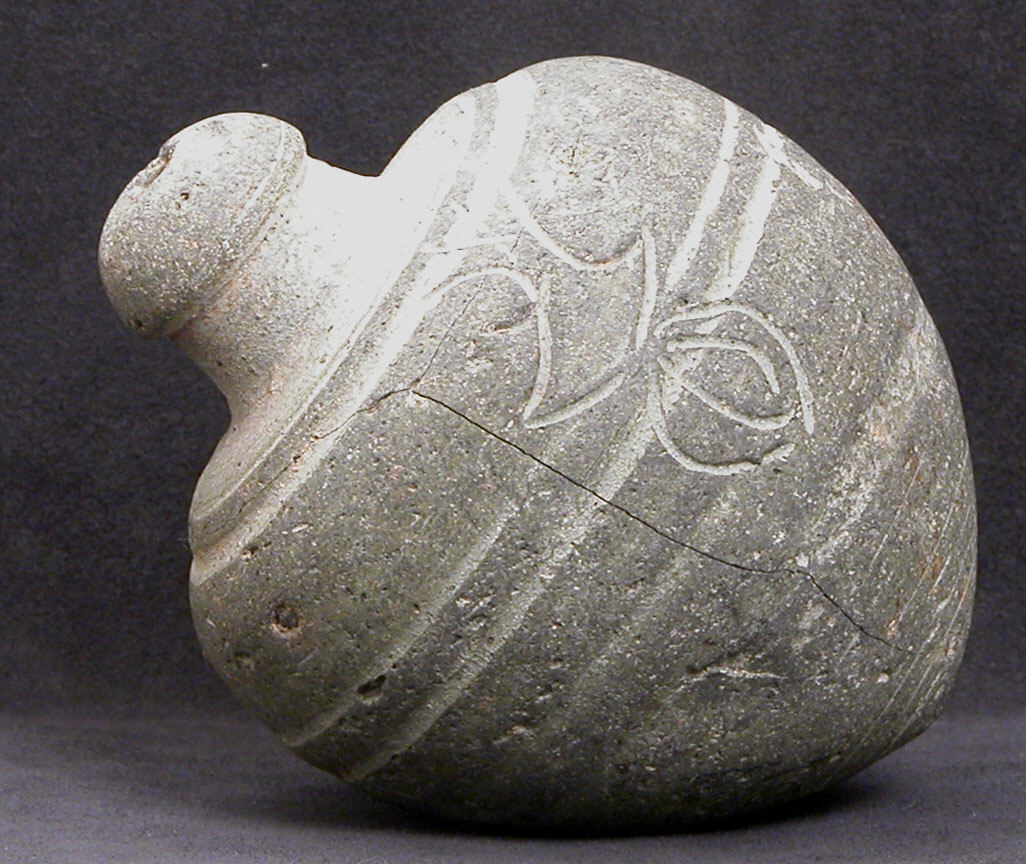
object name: vessel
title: Spheroconical Vessel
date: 801-1000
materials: earthenware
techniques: incising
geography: iran